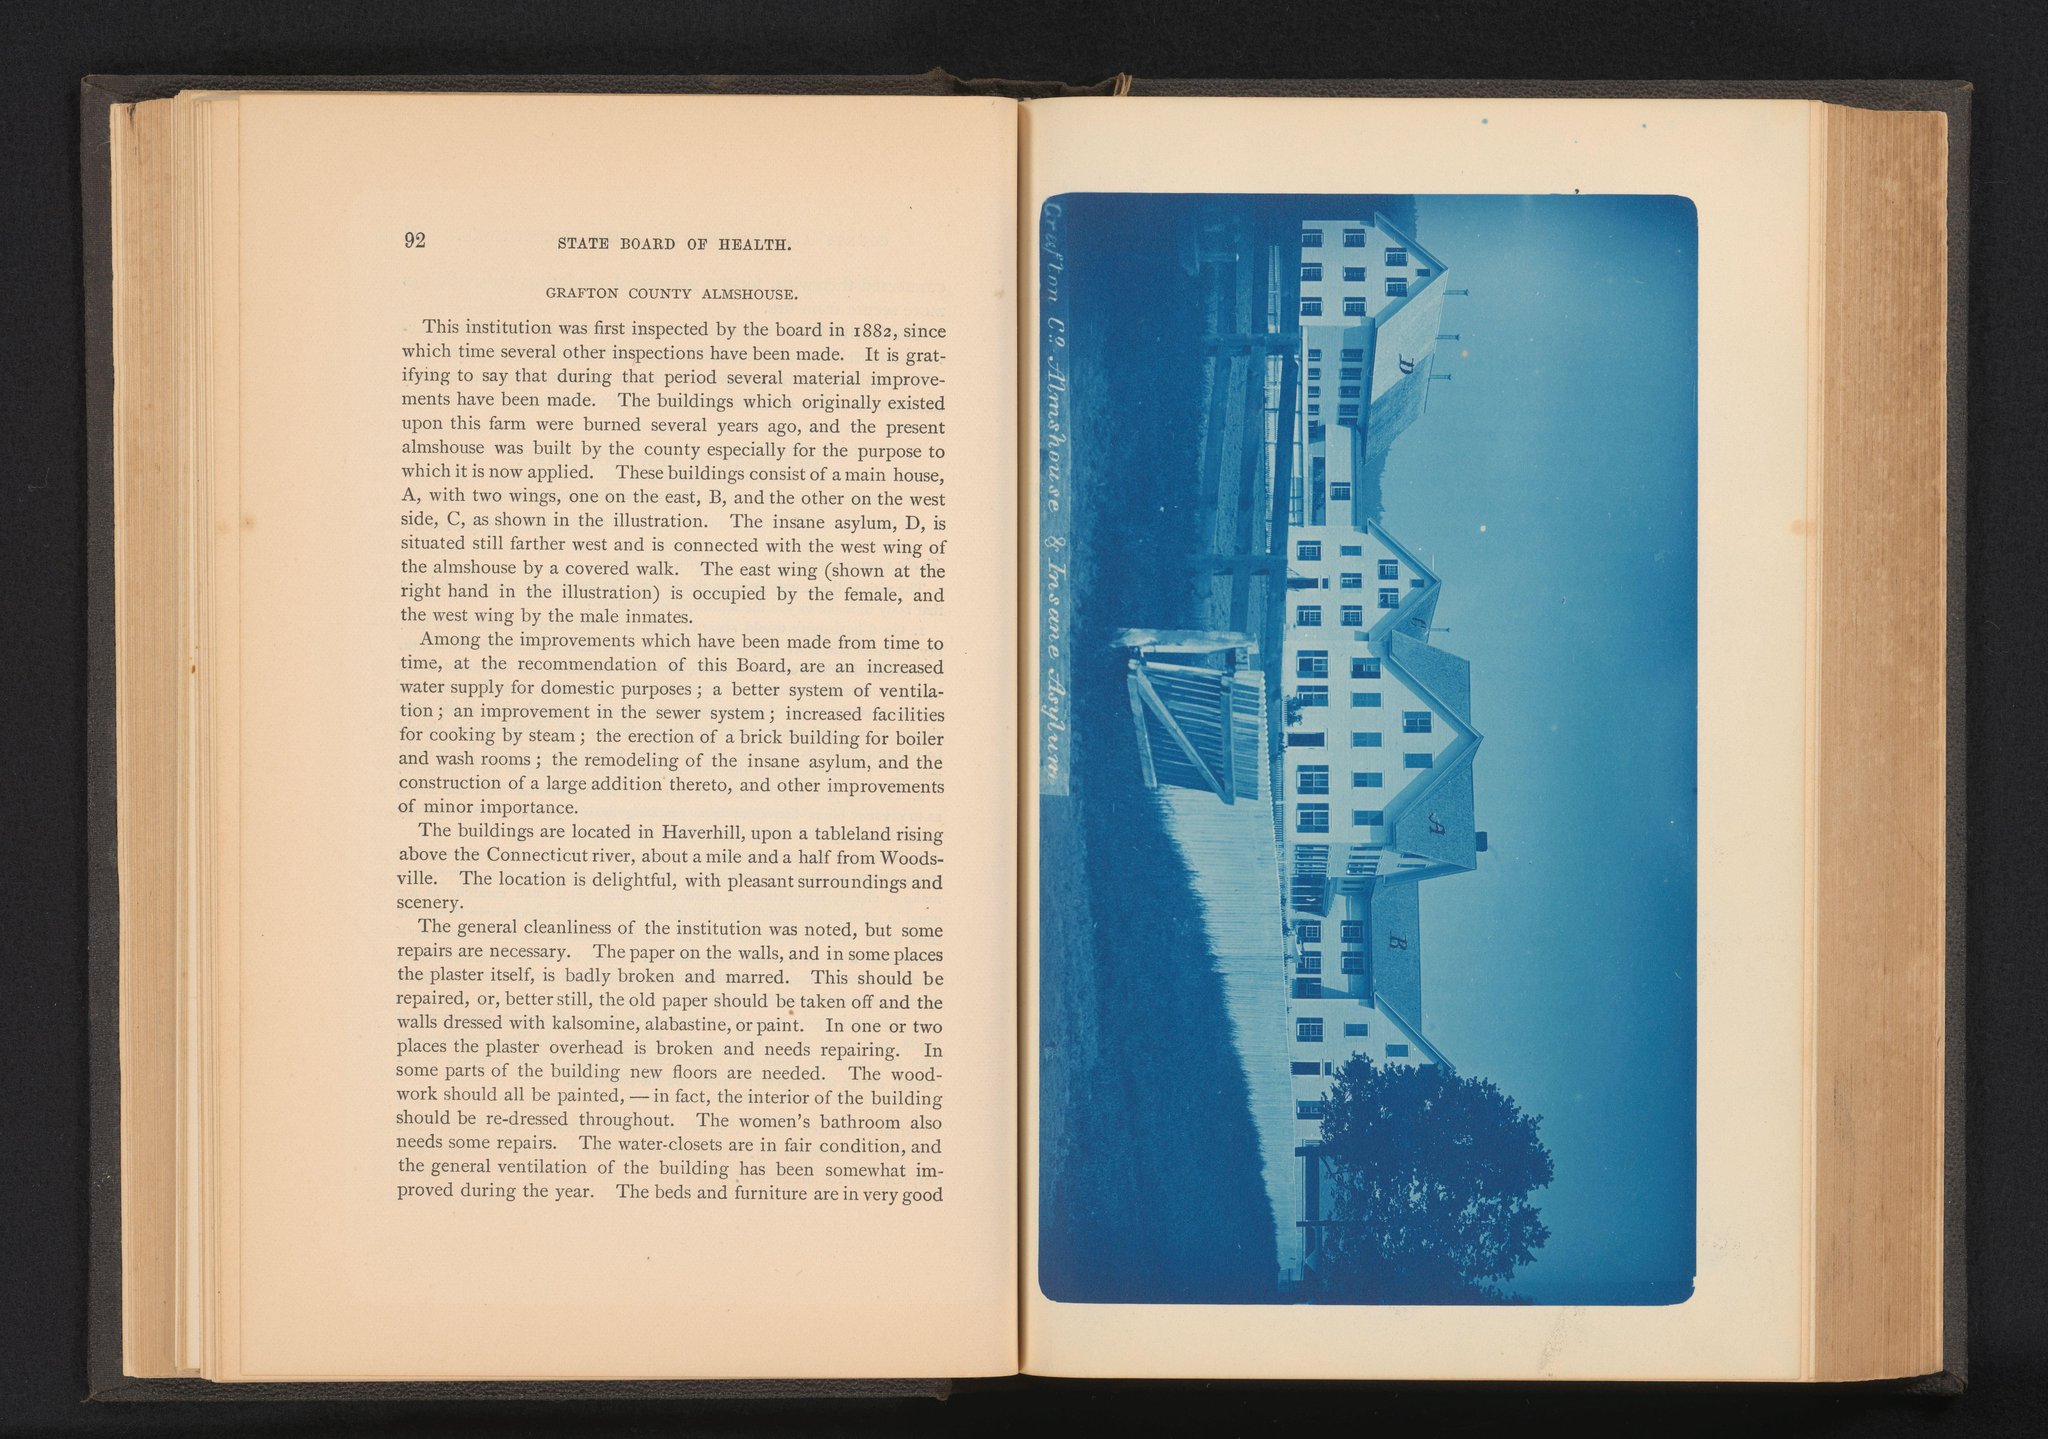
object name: photograph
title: Grafton Co. Almshouse & Insane Asylum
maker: Anonymous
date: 1884-1889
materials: photographic support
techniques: cyanotype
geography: haverhill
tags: alms-house (dutch: 'hofje'), façade (of house or building), lunatic asylum, mental home